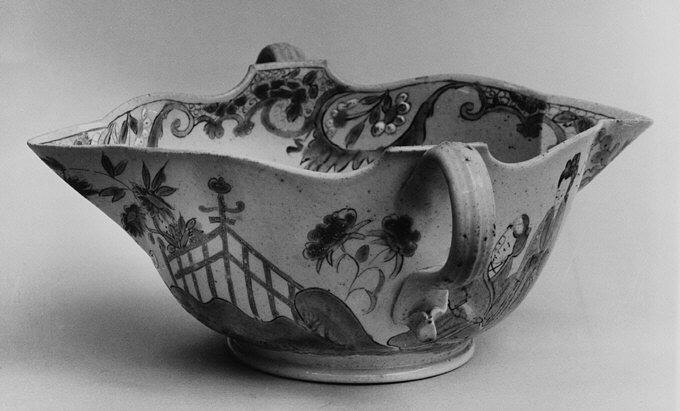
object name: sauceboat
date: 1750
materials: stoneware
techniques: salt glaze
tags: human figures,flowers